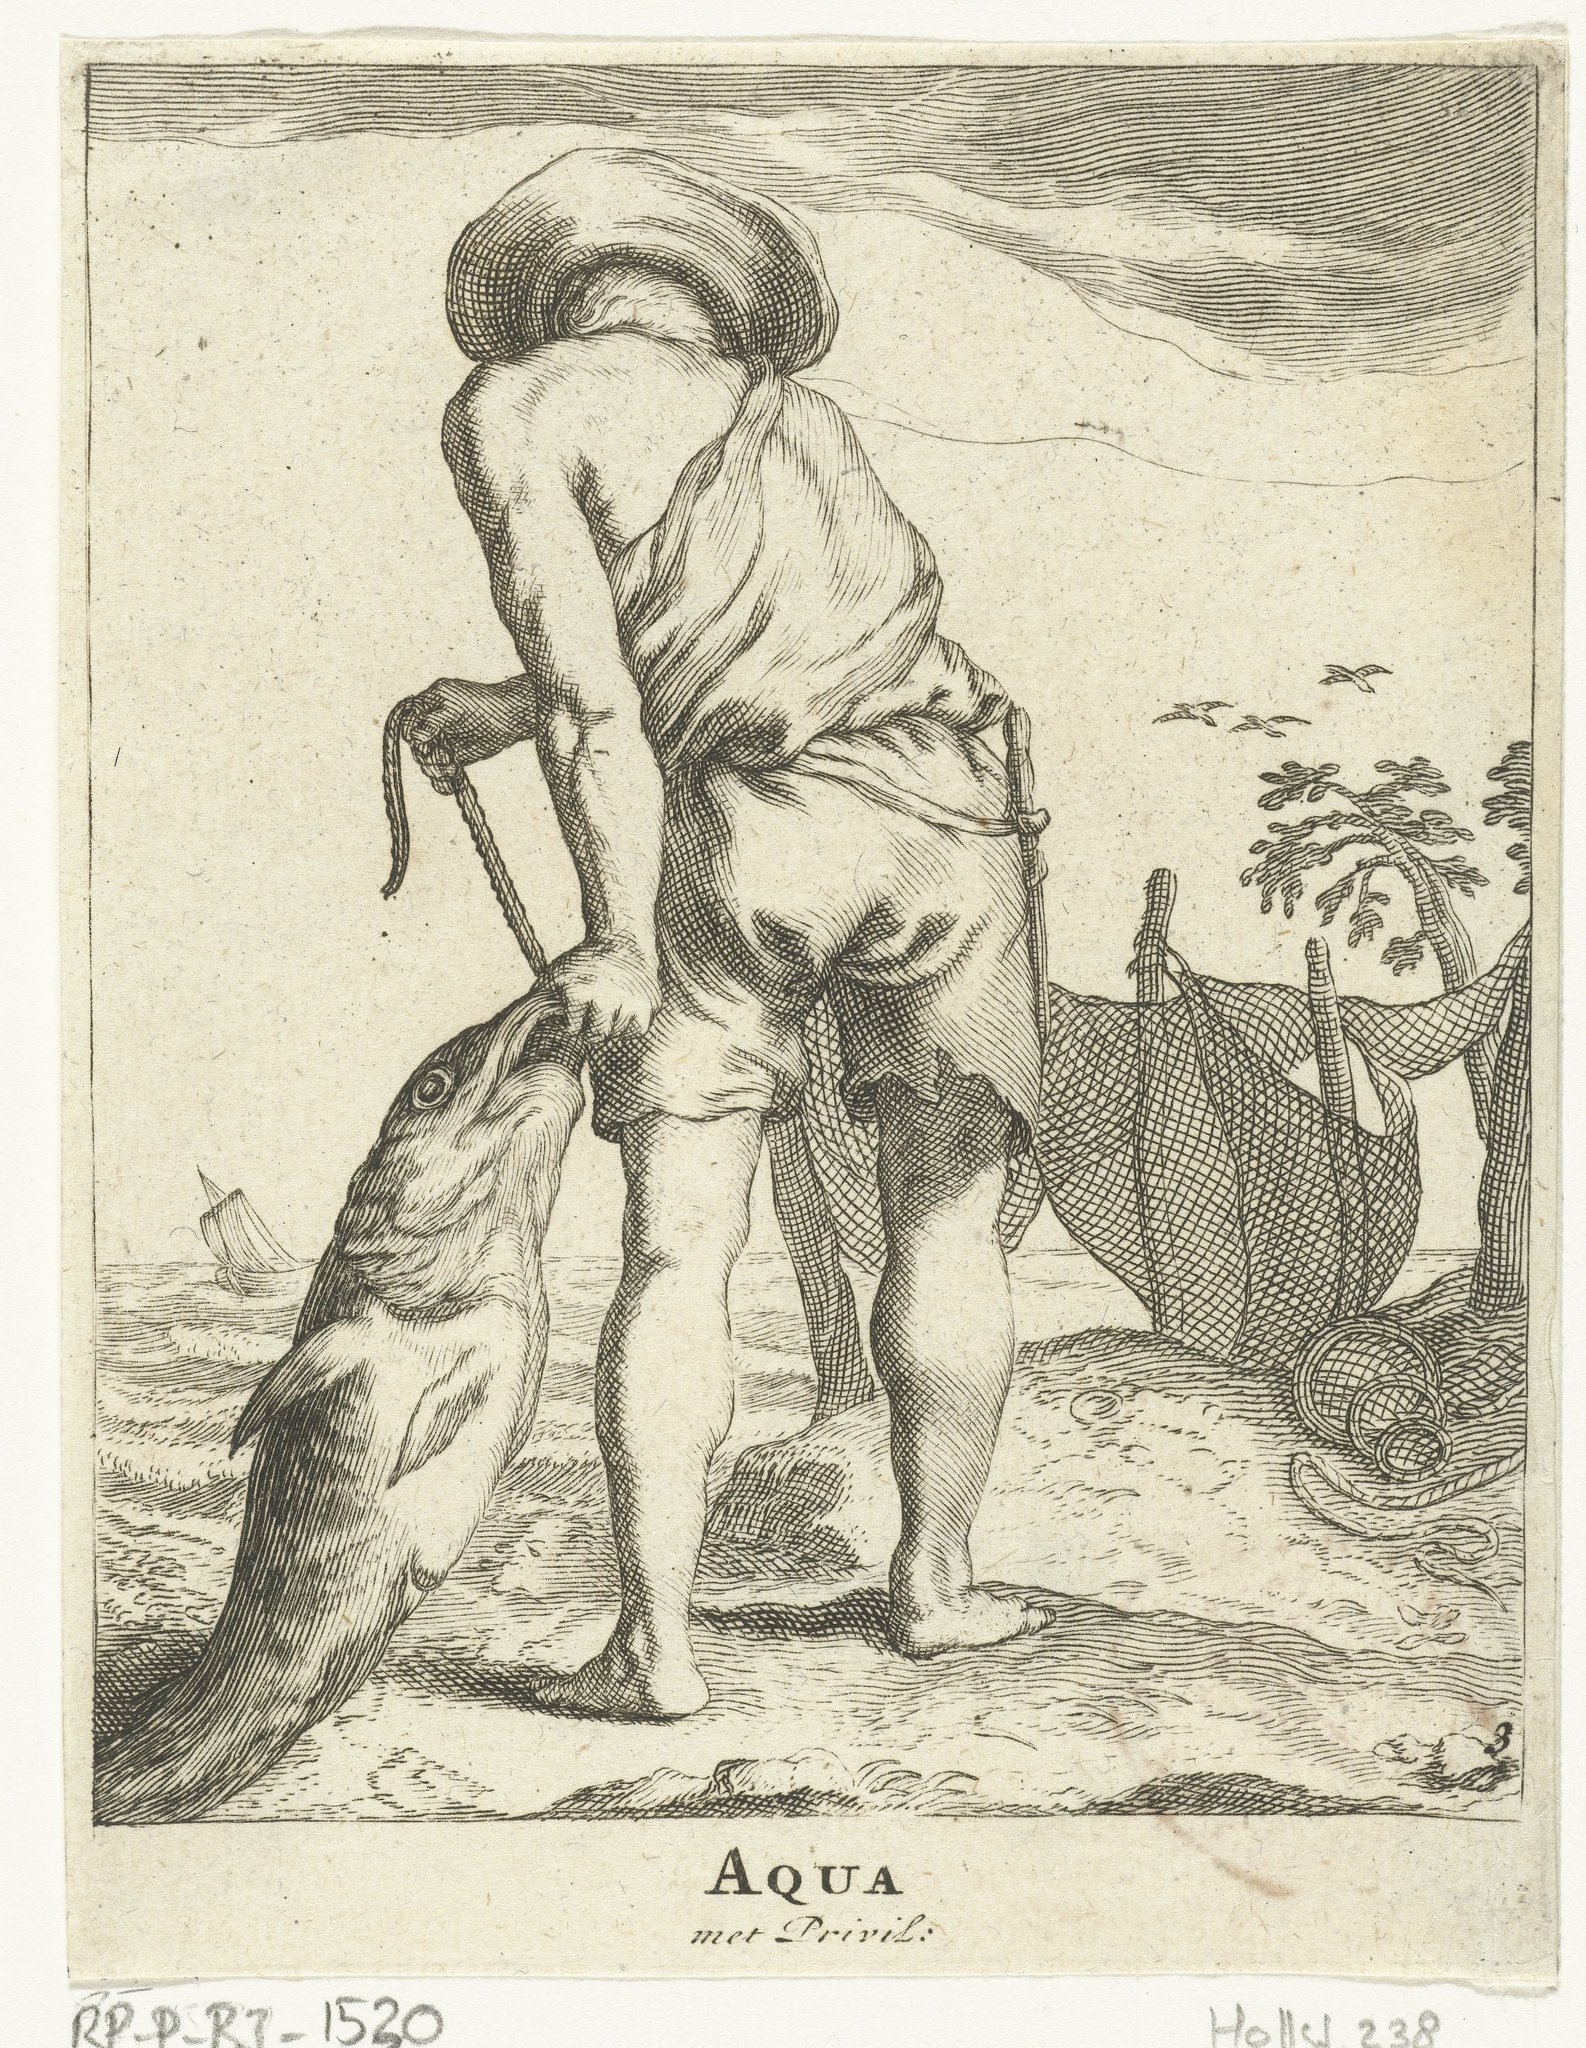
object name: print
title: Aqua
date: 1632-1670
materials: paper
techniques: engraving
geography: amsterdam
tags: water (one of the four elements), fisherman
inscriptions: collector's mark: Lugt 240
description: Een visser trekt zijn vangst aan land. Op de achtergrond hangt een groot net te drogen.